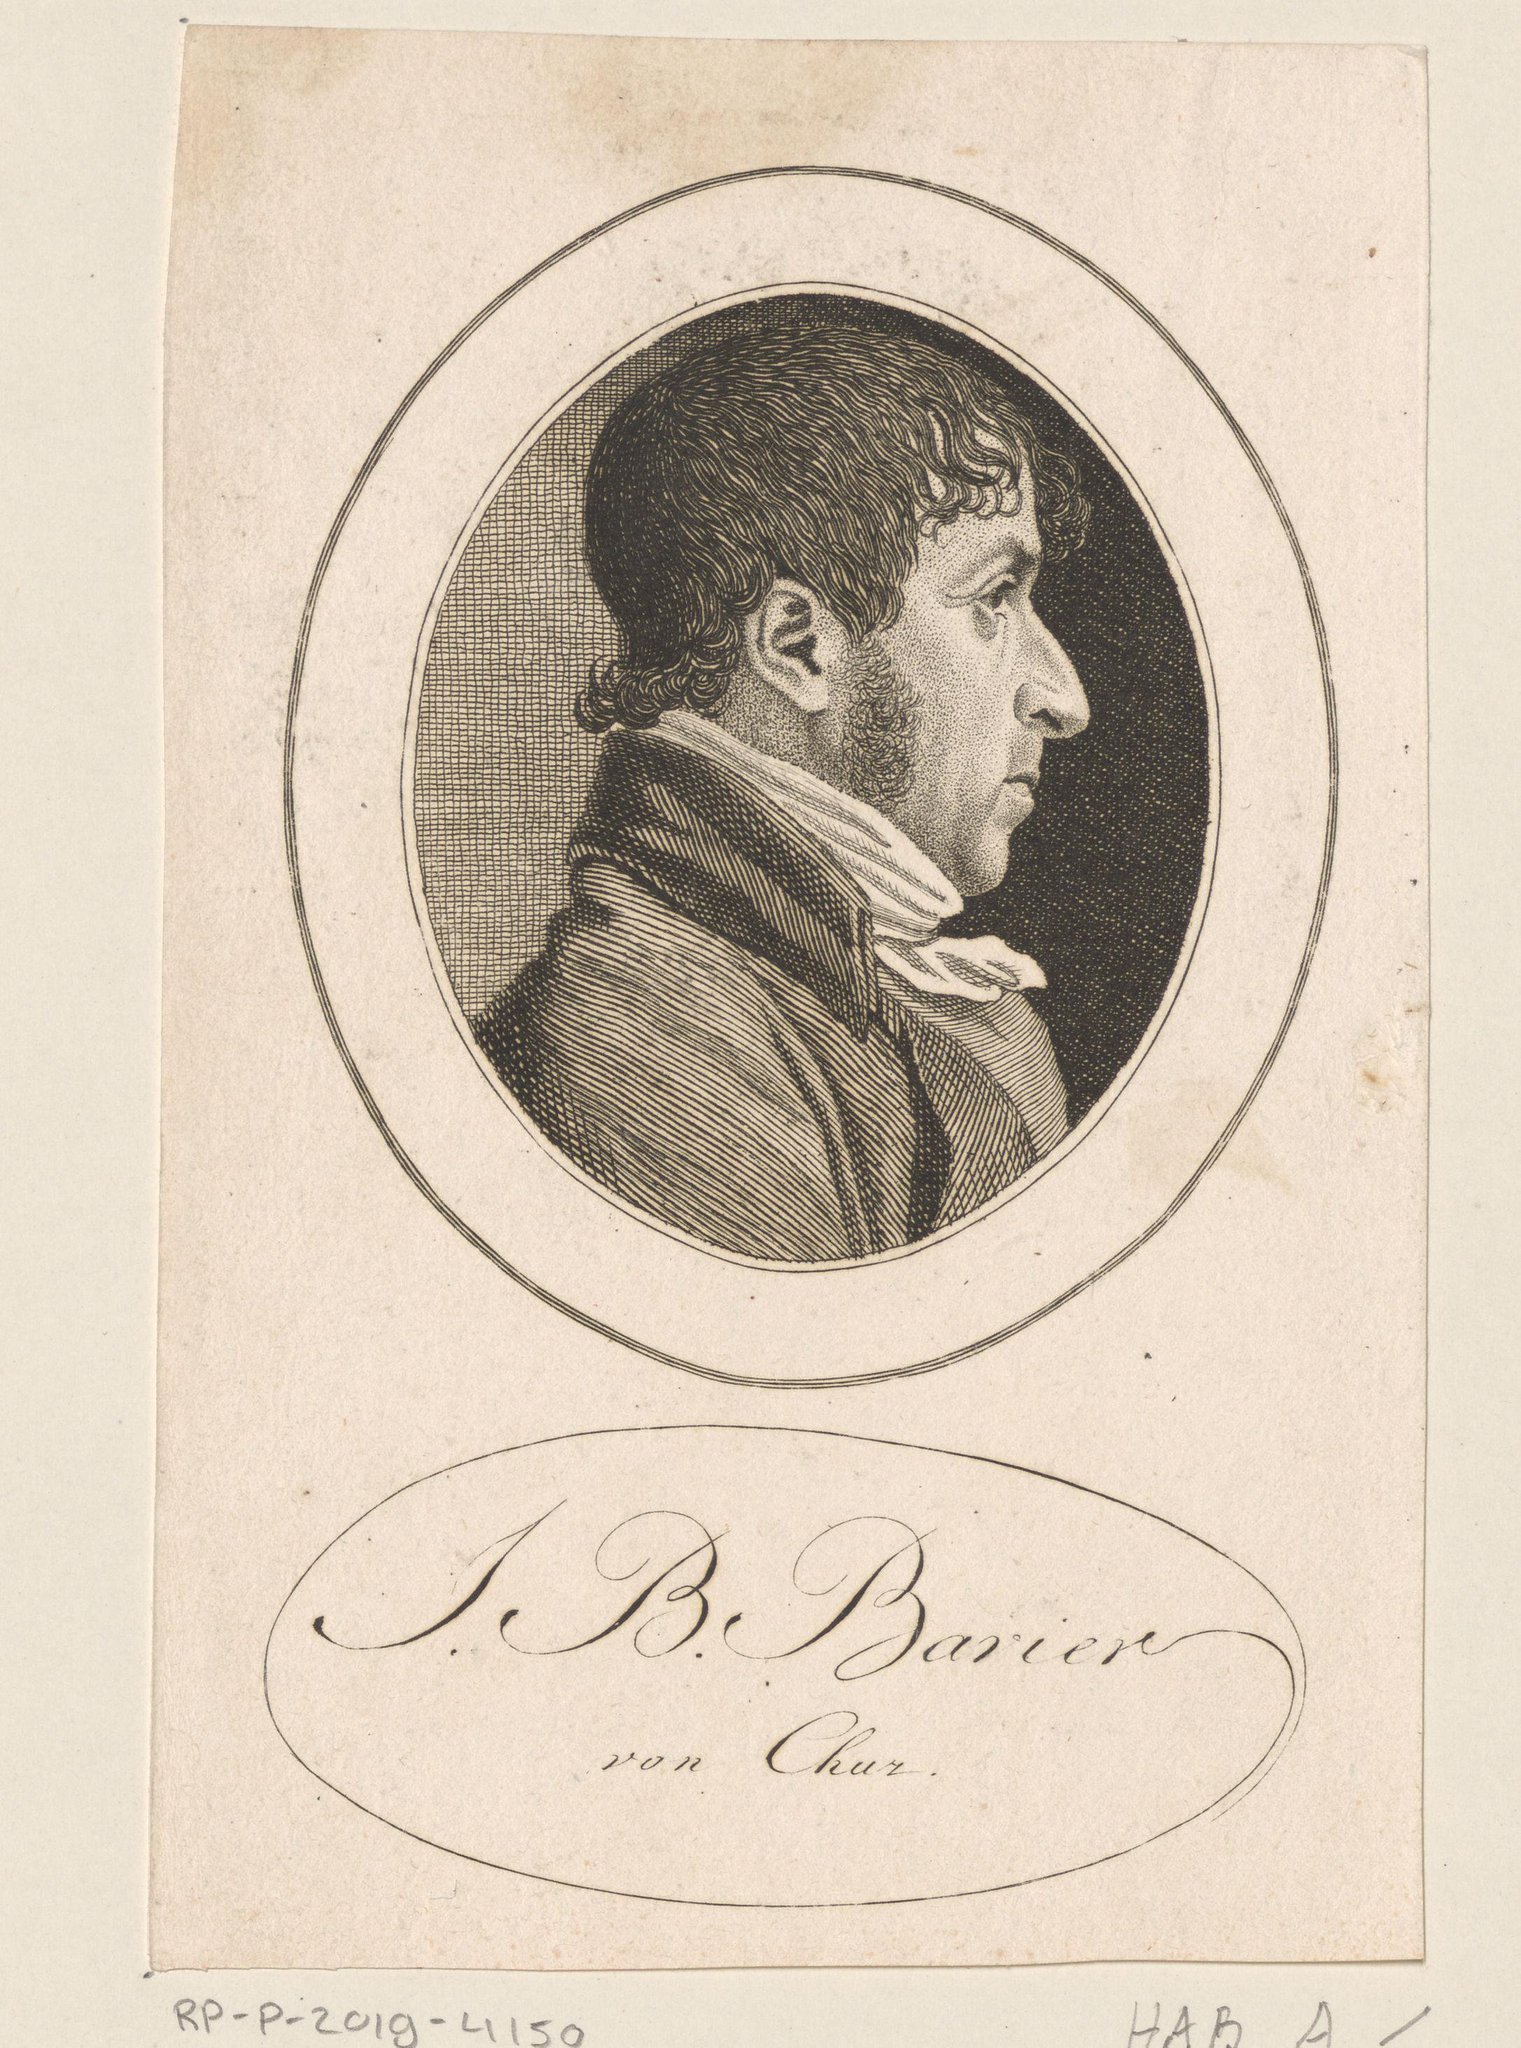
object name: print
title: Portret van J.B. Barier van Chur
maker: Anonymous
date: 1800-1849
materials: paper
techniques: engraving, etching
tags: historical persons